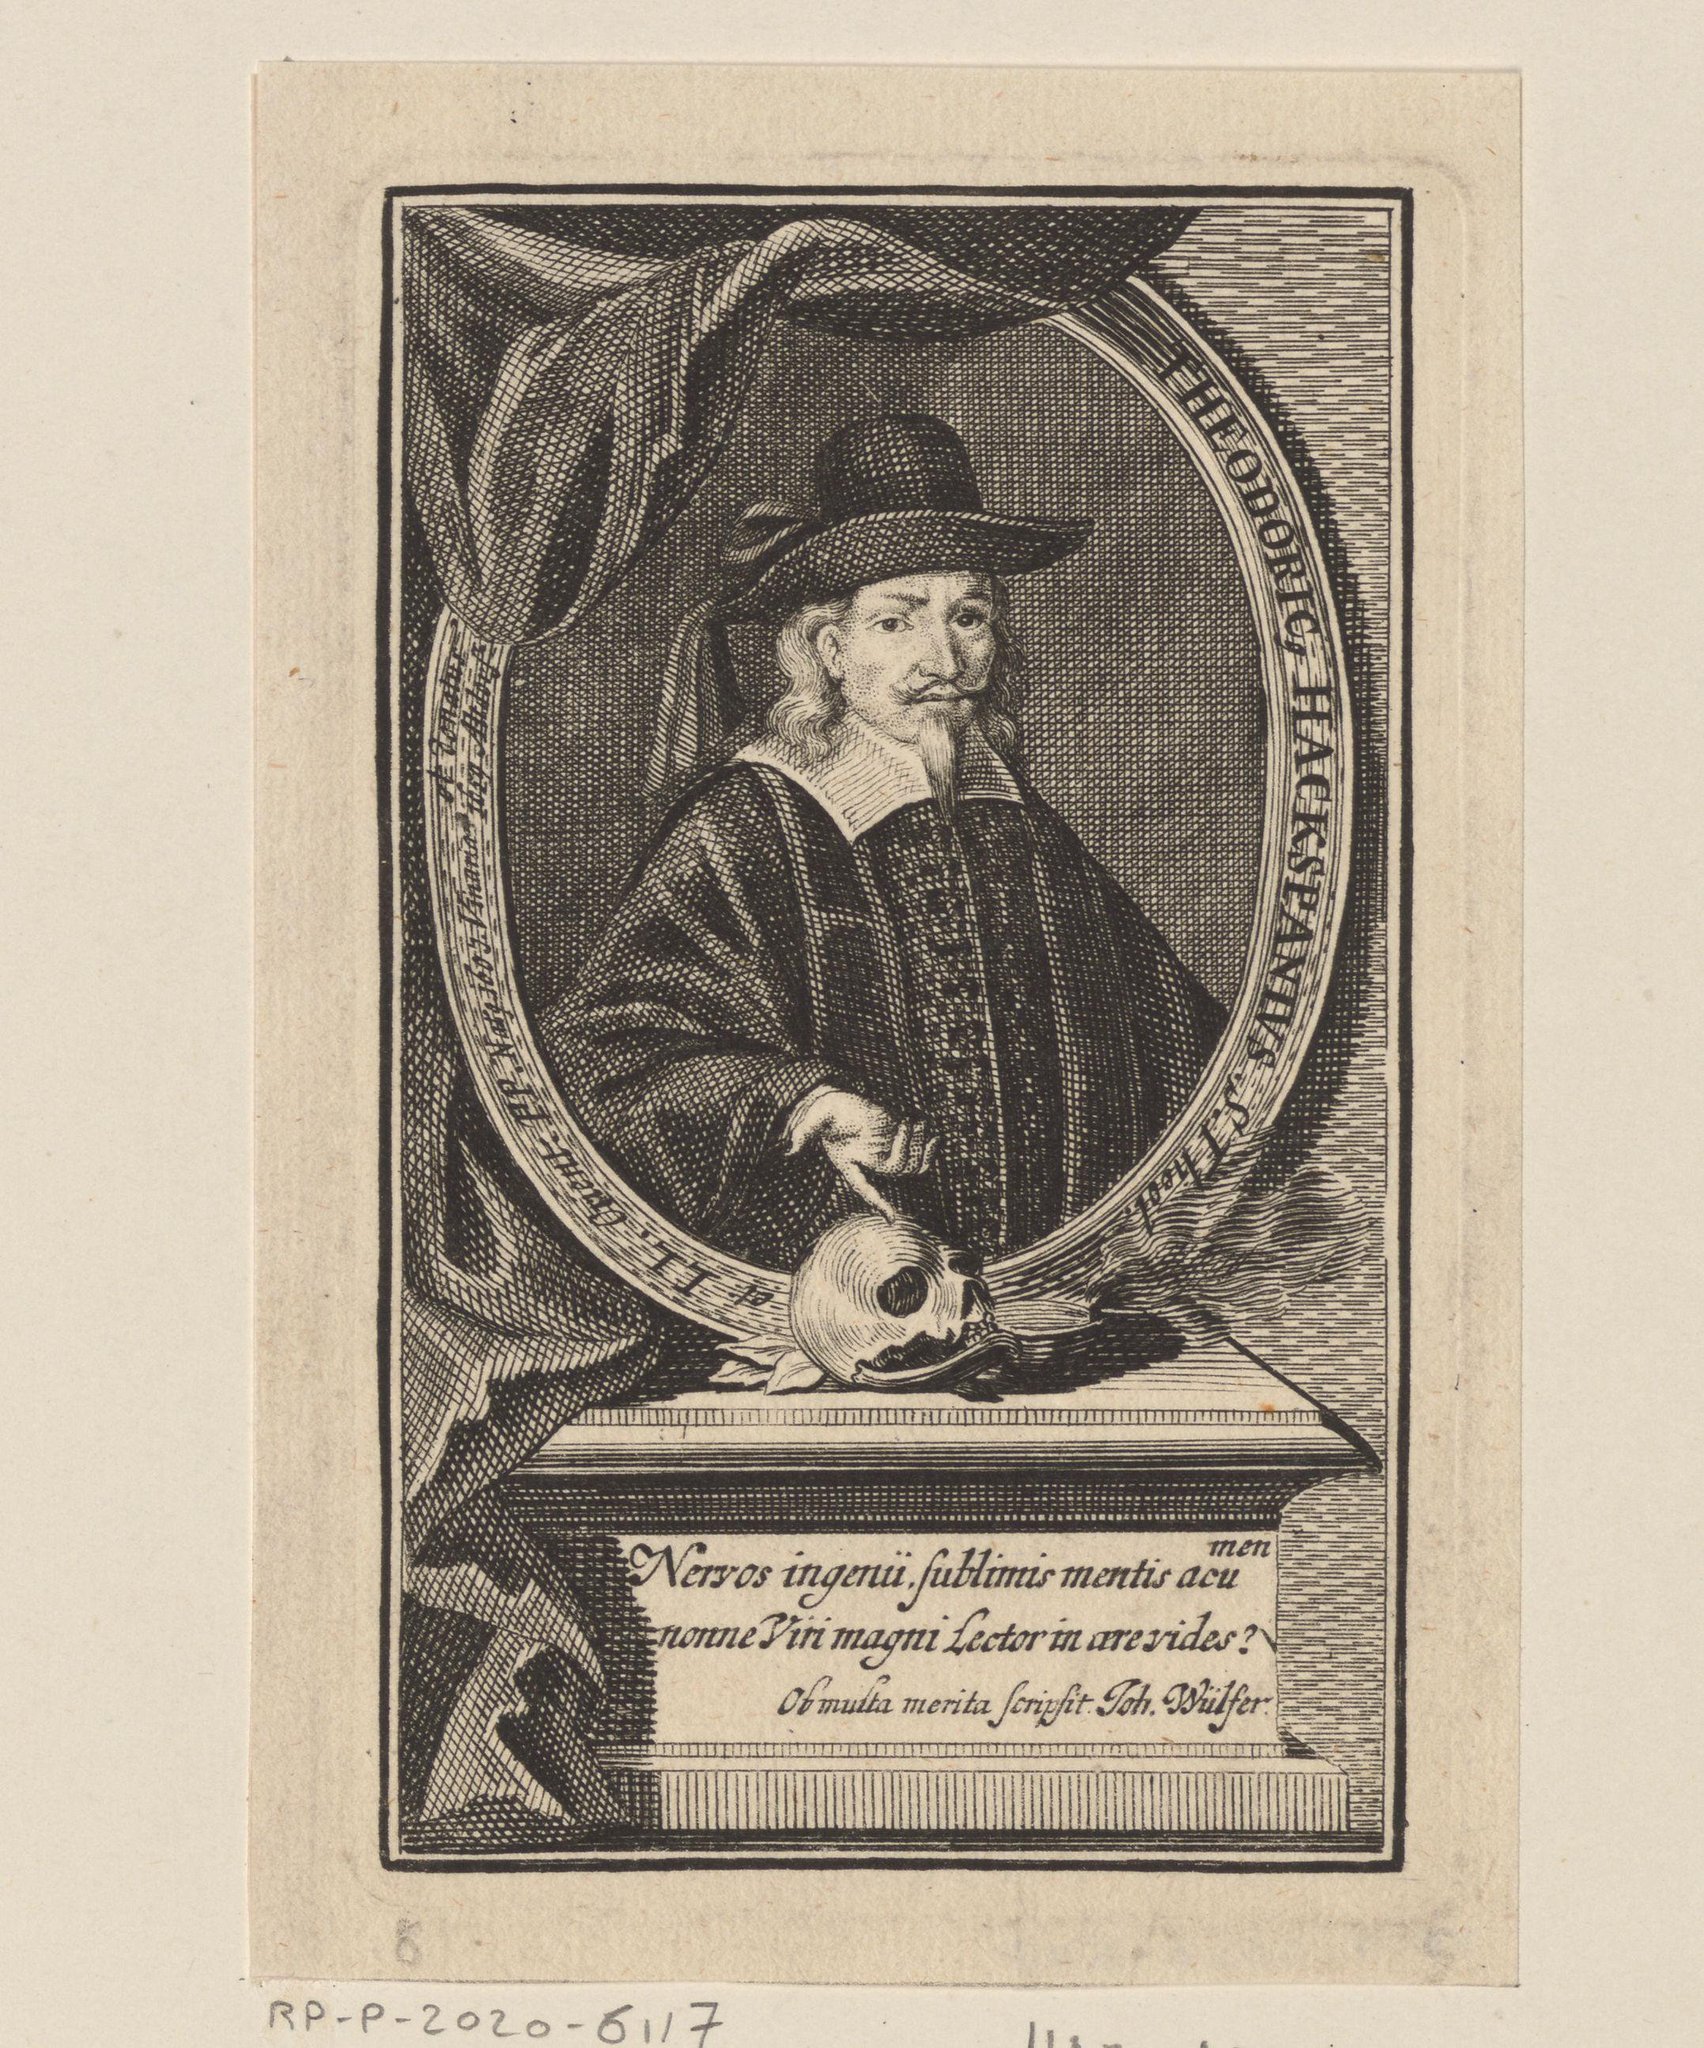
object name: print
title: Portret van Theodoricus Hackspan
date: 1659-1699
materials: paper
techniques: engraving, etching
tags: historical persons, professor, death's head, skull (symbol of death)